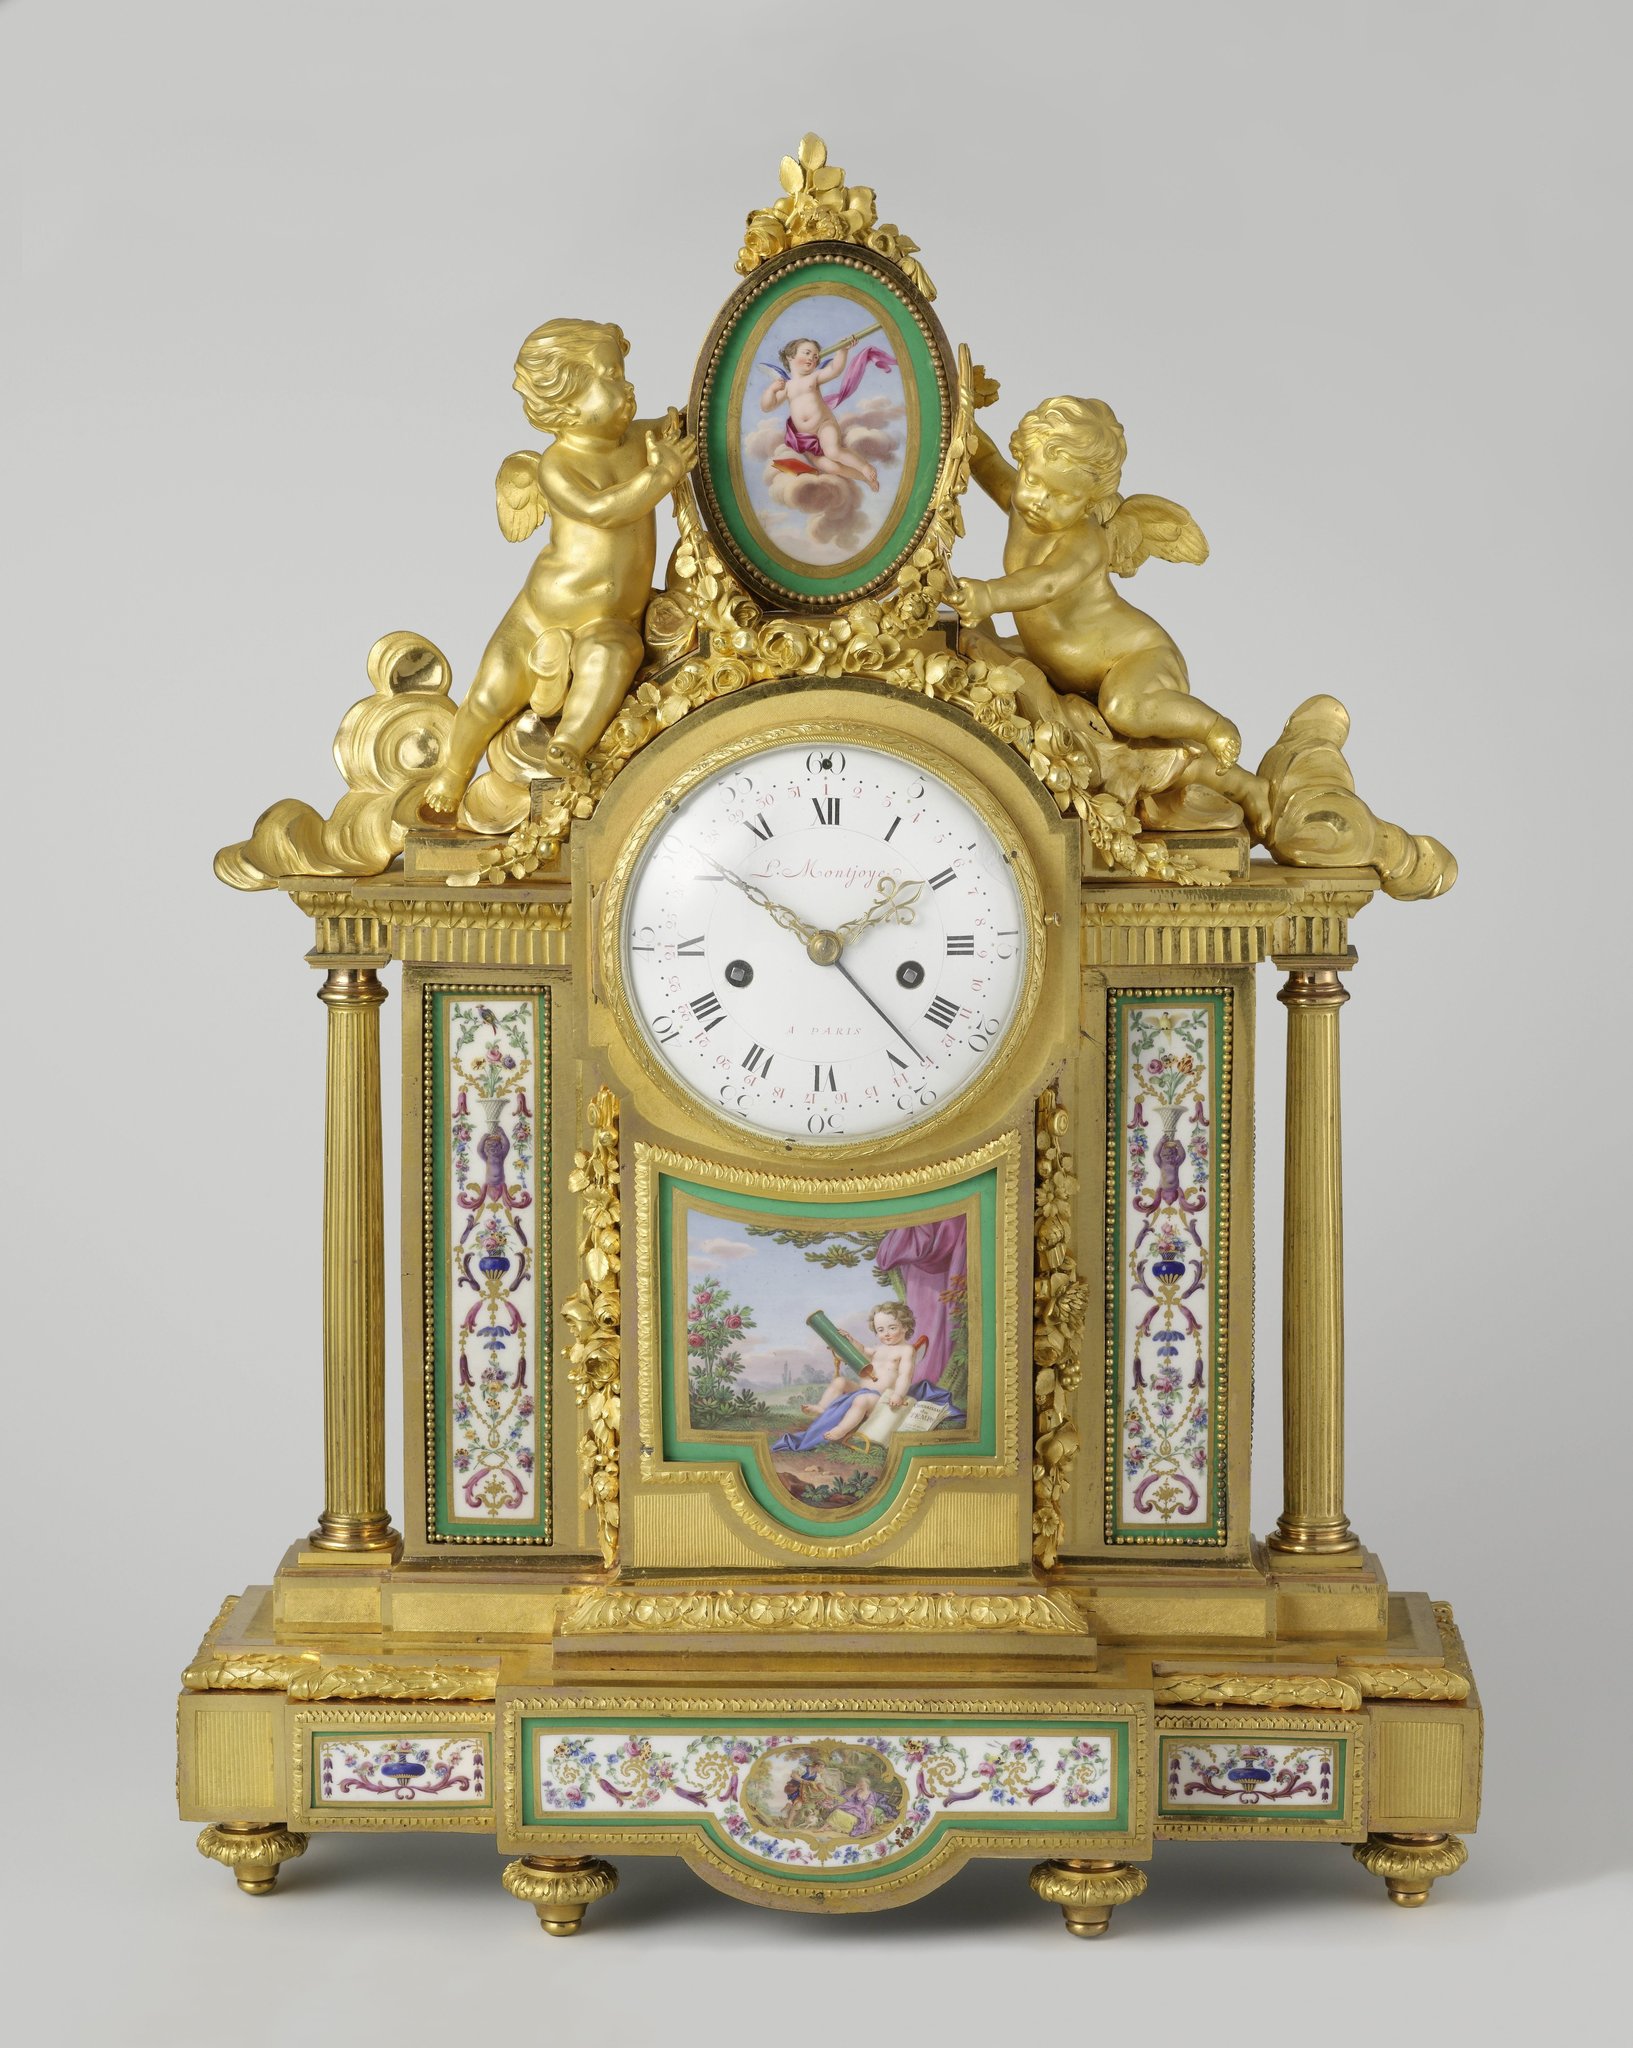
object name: clock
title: Mantel clock (pendule)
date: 1781-1782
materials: brass, bronze, porcelain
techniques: gilding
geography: sèvres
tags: poland, maria féodorowna, paul i (tsaar van rusland), ornaments ~ art, cupids: 'amores', 'amoretti', 'putti', binoculars, spy-glass, etc.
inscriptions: signature: ‘L. Montjoye/ A Paris’, signature: ‘montjoye a Cantième’, inscription: ‘CONNAISSANCE/ des/ TEMPS’, signature: ‘G Merlet’, signature: ‘Louis Montjoye AParis’, inscription: ‘Richard x 1781’, inscription: ‘Richard x 1781’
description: In 1782 Grand Duke Paul of Russia, the later Tsar Paul I, and his consort, Maria Feodorovna, bought this expen-sive showpiece from the Parisian dealer (marchand-mercier) Dominique Daguerre. With its combination of splendidly worked gilt-bronze (ormolu) and Sèvres porcelain, this clock is a spectacular demonstration of the unrivalled quality of Parisian craftsmanship.